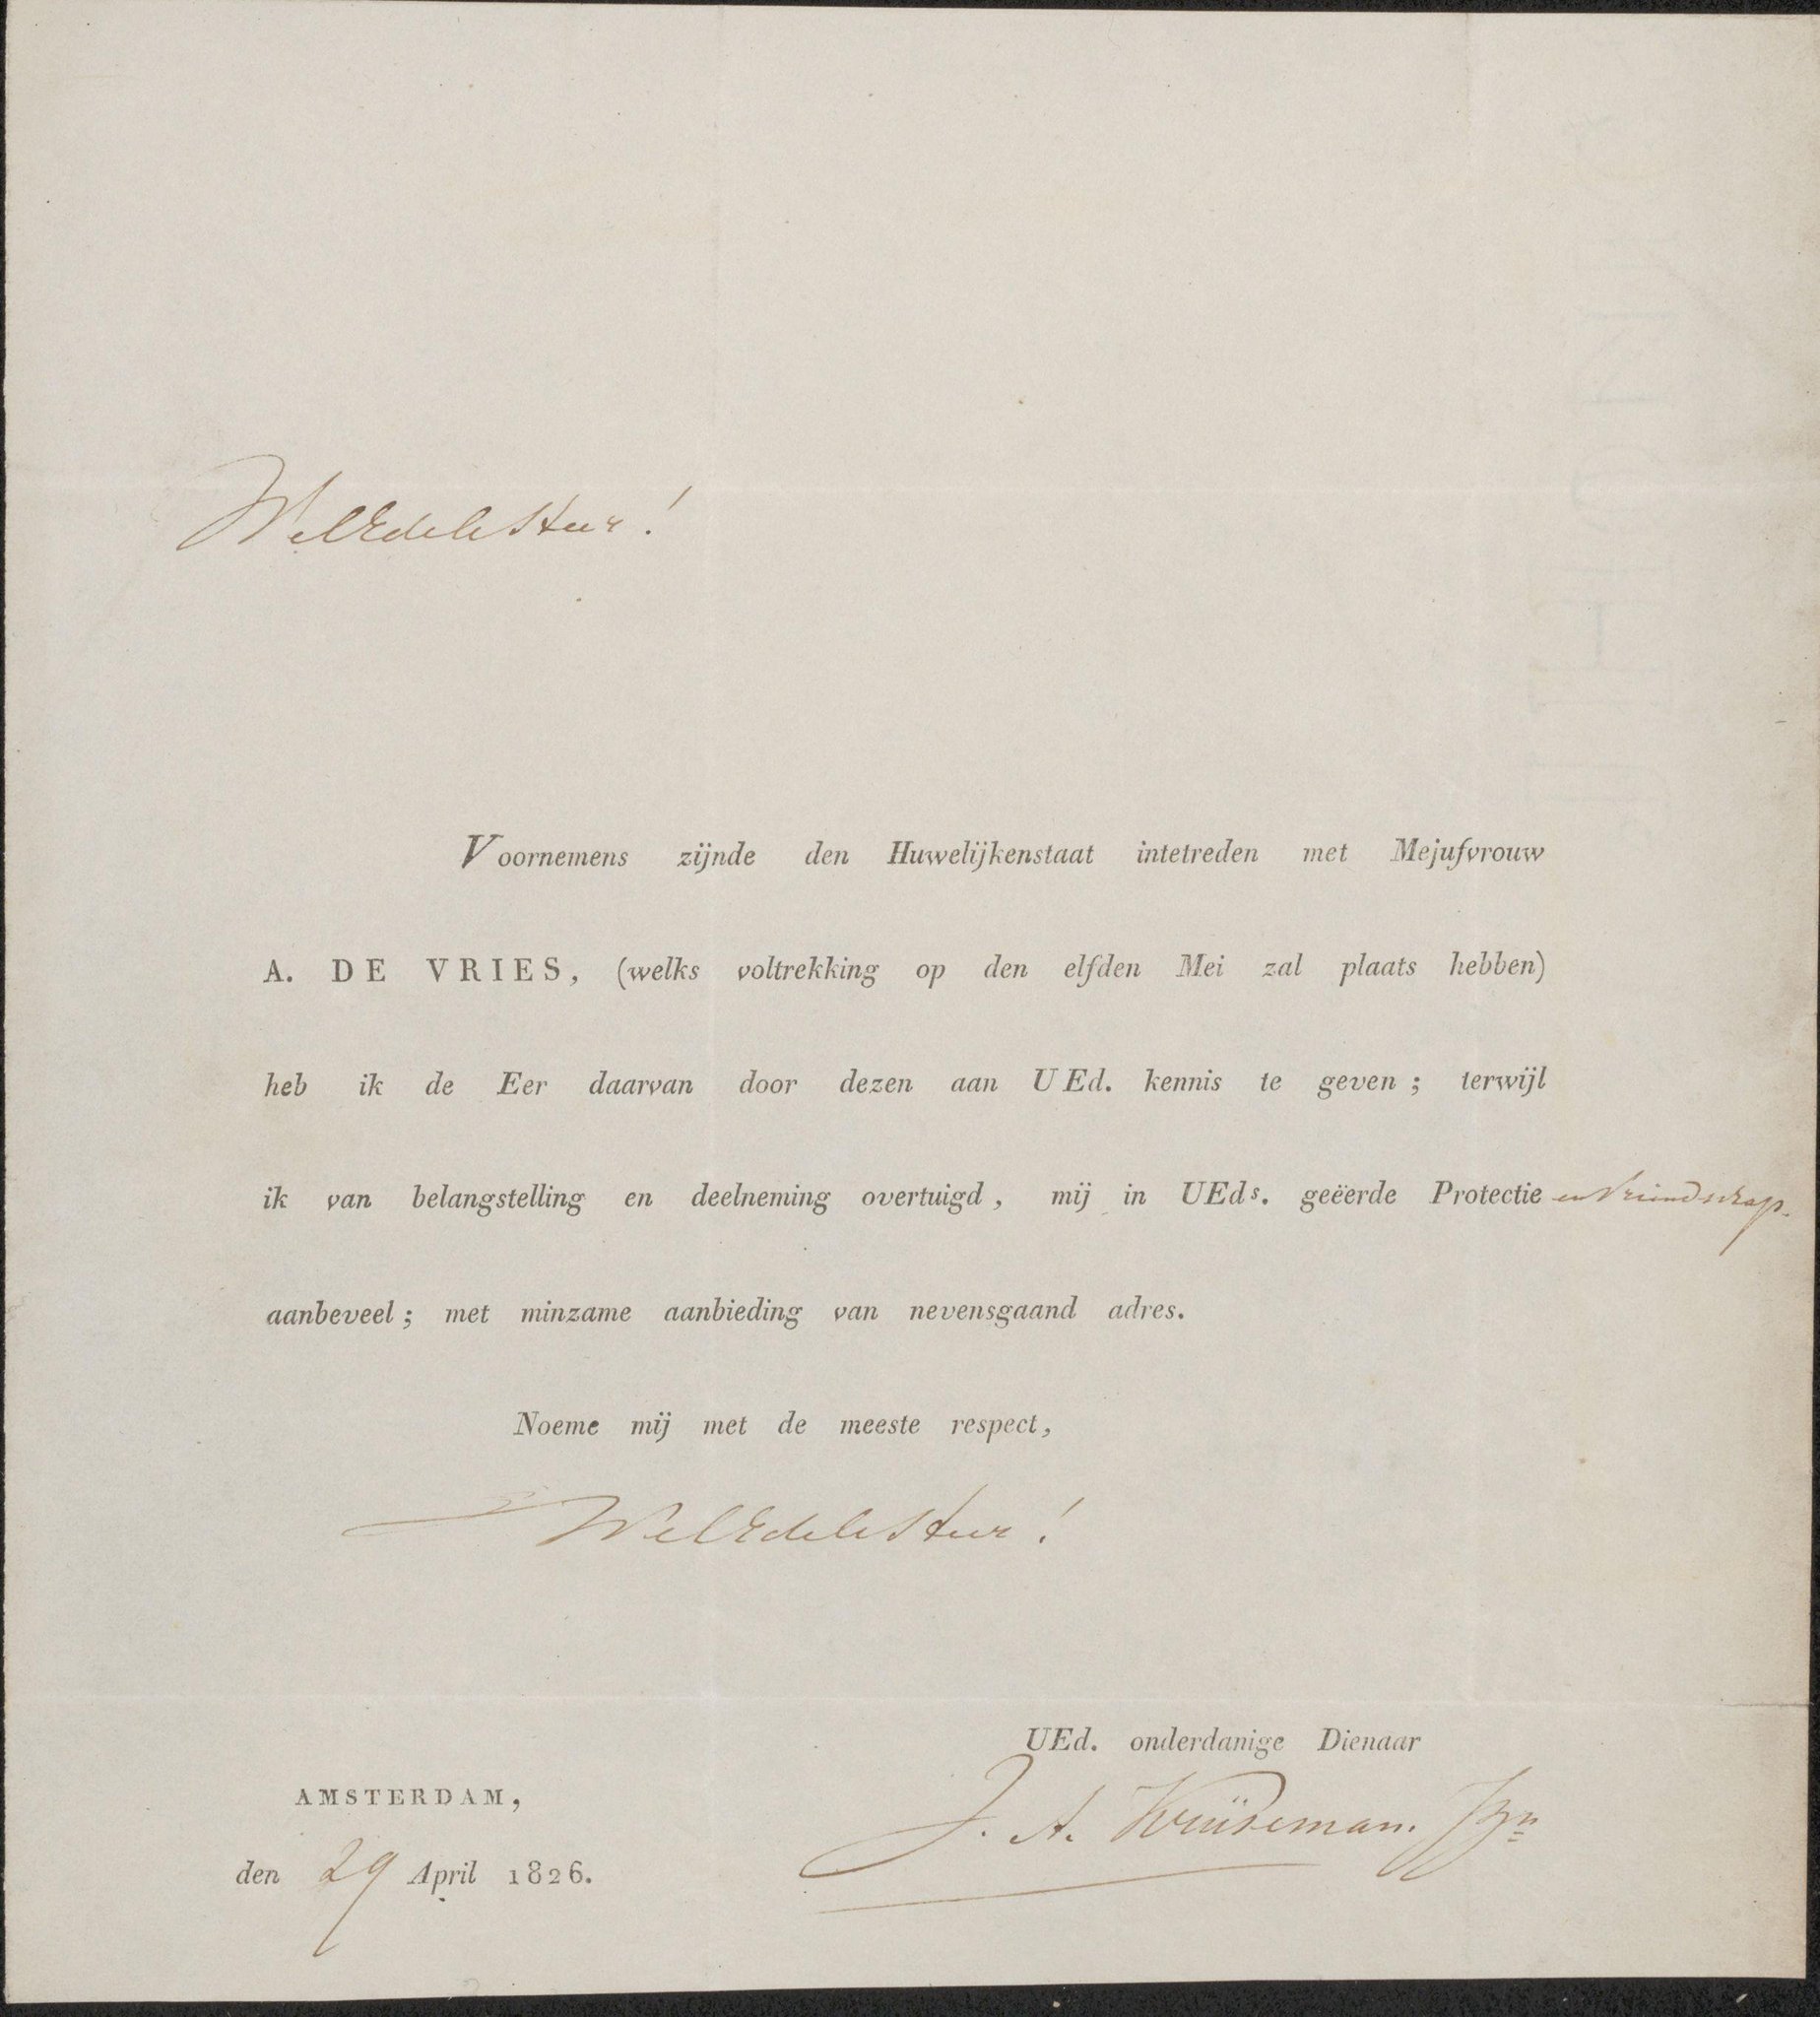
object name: wedding announcement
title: Huwelijksaankondiging aan anoniem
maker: Anonymous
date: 1826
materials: ink, paper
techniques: pen, printing, writing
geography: amsterdam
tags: haarlem, painter, print maker, draughtsman, jan adam kruseman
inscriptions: watermark